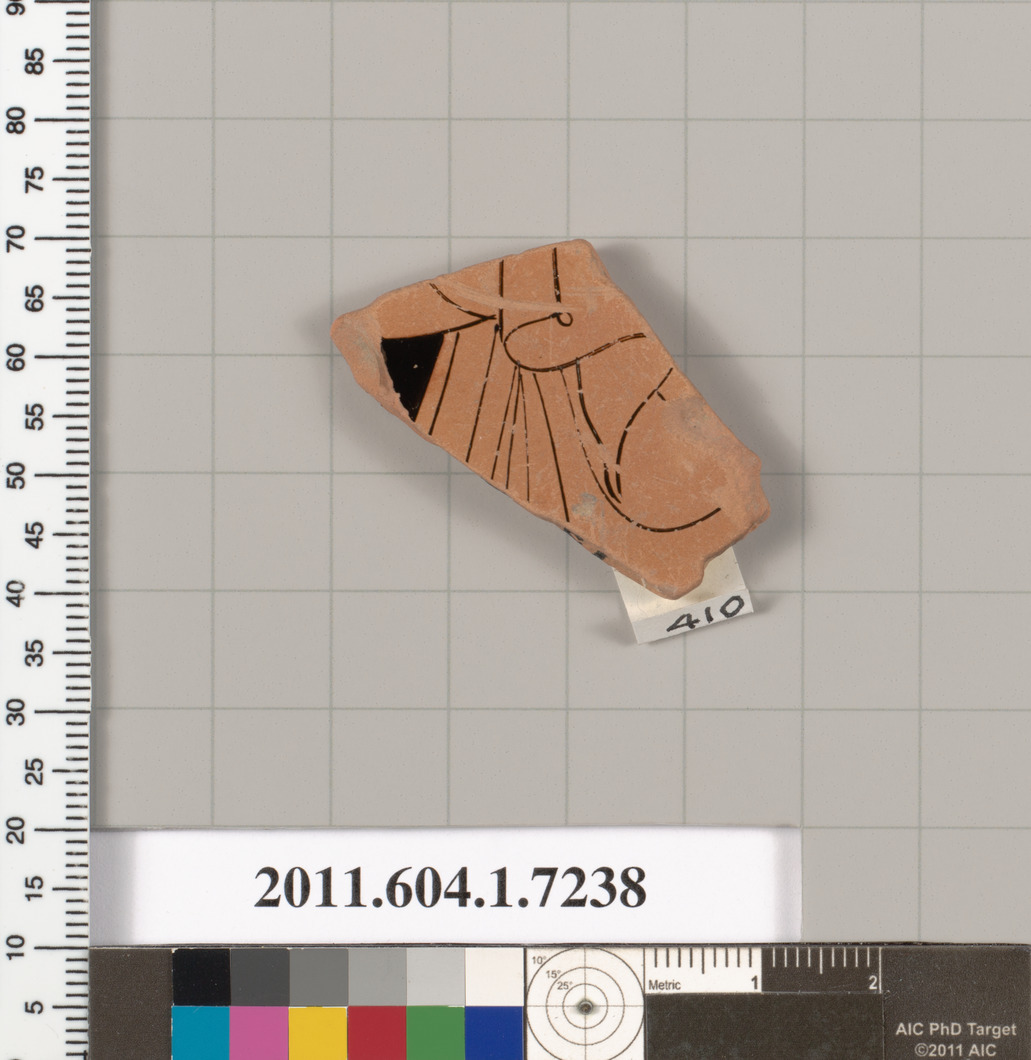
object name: kylix fragment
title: Terracotta fragment of a kylix (drinking cup)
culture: greek, attic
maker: makron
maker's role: artist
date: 500-480 BCE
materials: terracotta